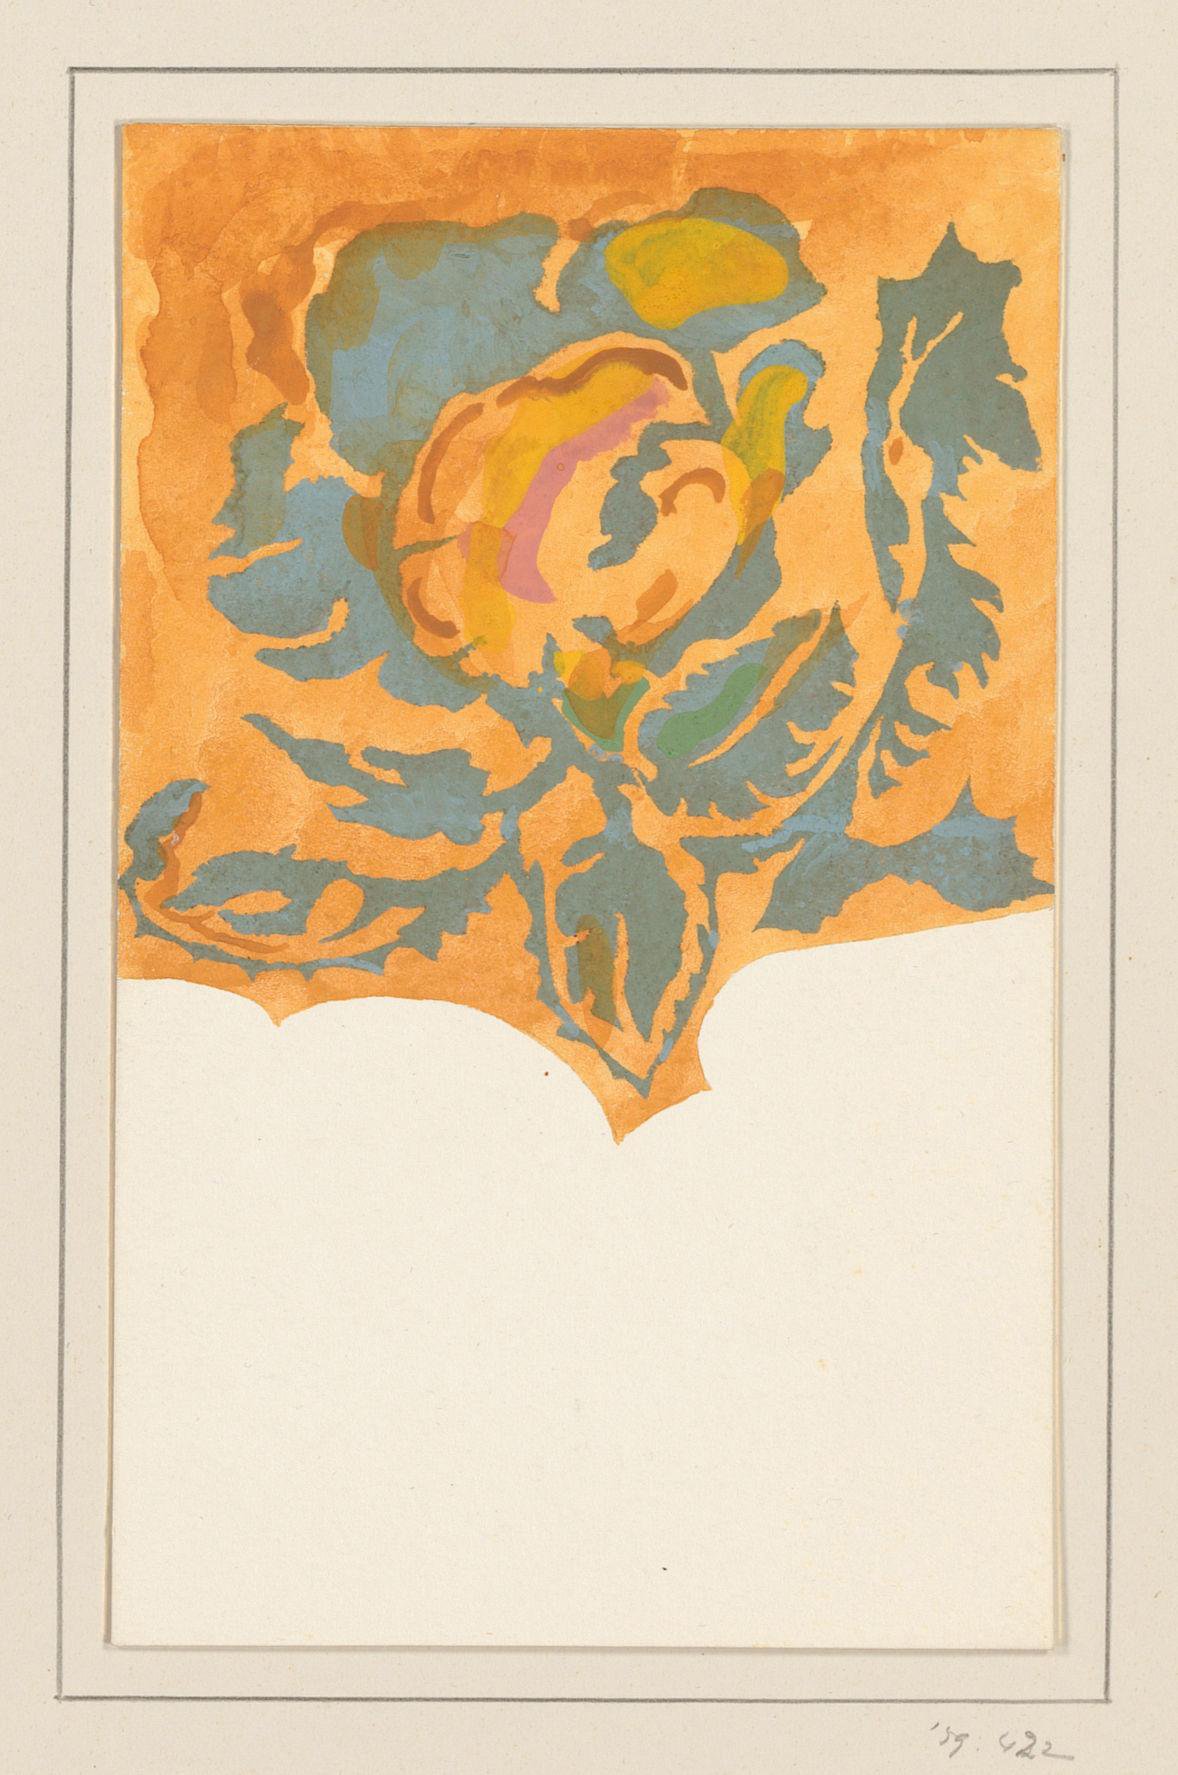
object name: drawing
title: Ontwerp voor een menukaart met bloemmotief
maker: theo colenbrander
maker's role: draughtsman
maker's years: 1841-1930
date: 1851-1930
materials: paper, pencil, watercolor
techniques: brush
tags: ornament derived from plant forms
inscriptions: number: ‘8.’, inscription: ‘menu van Colenbrander’